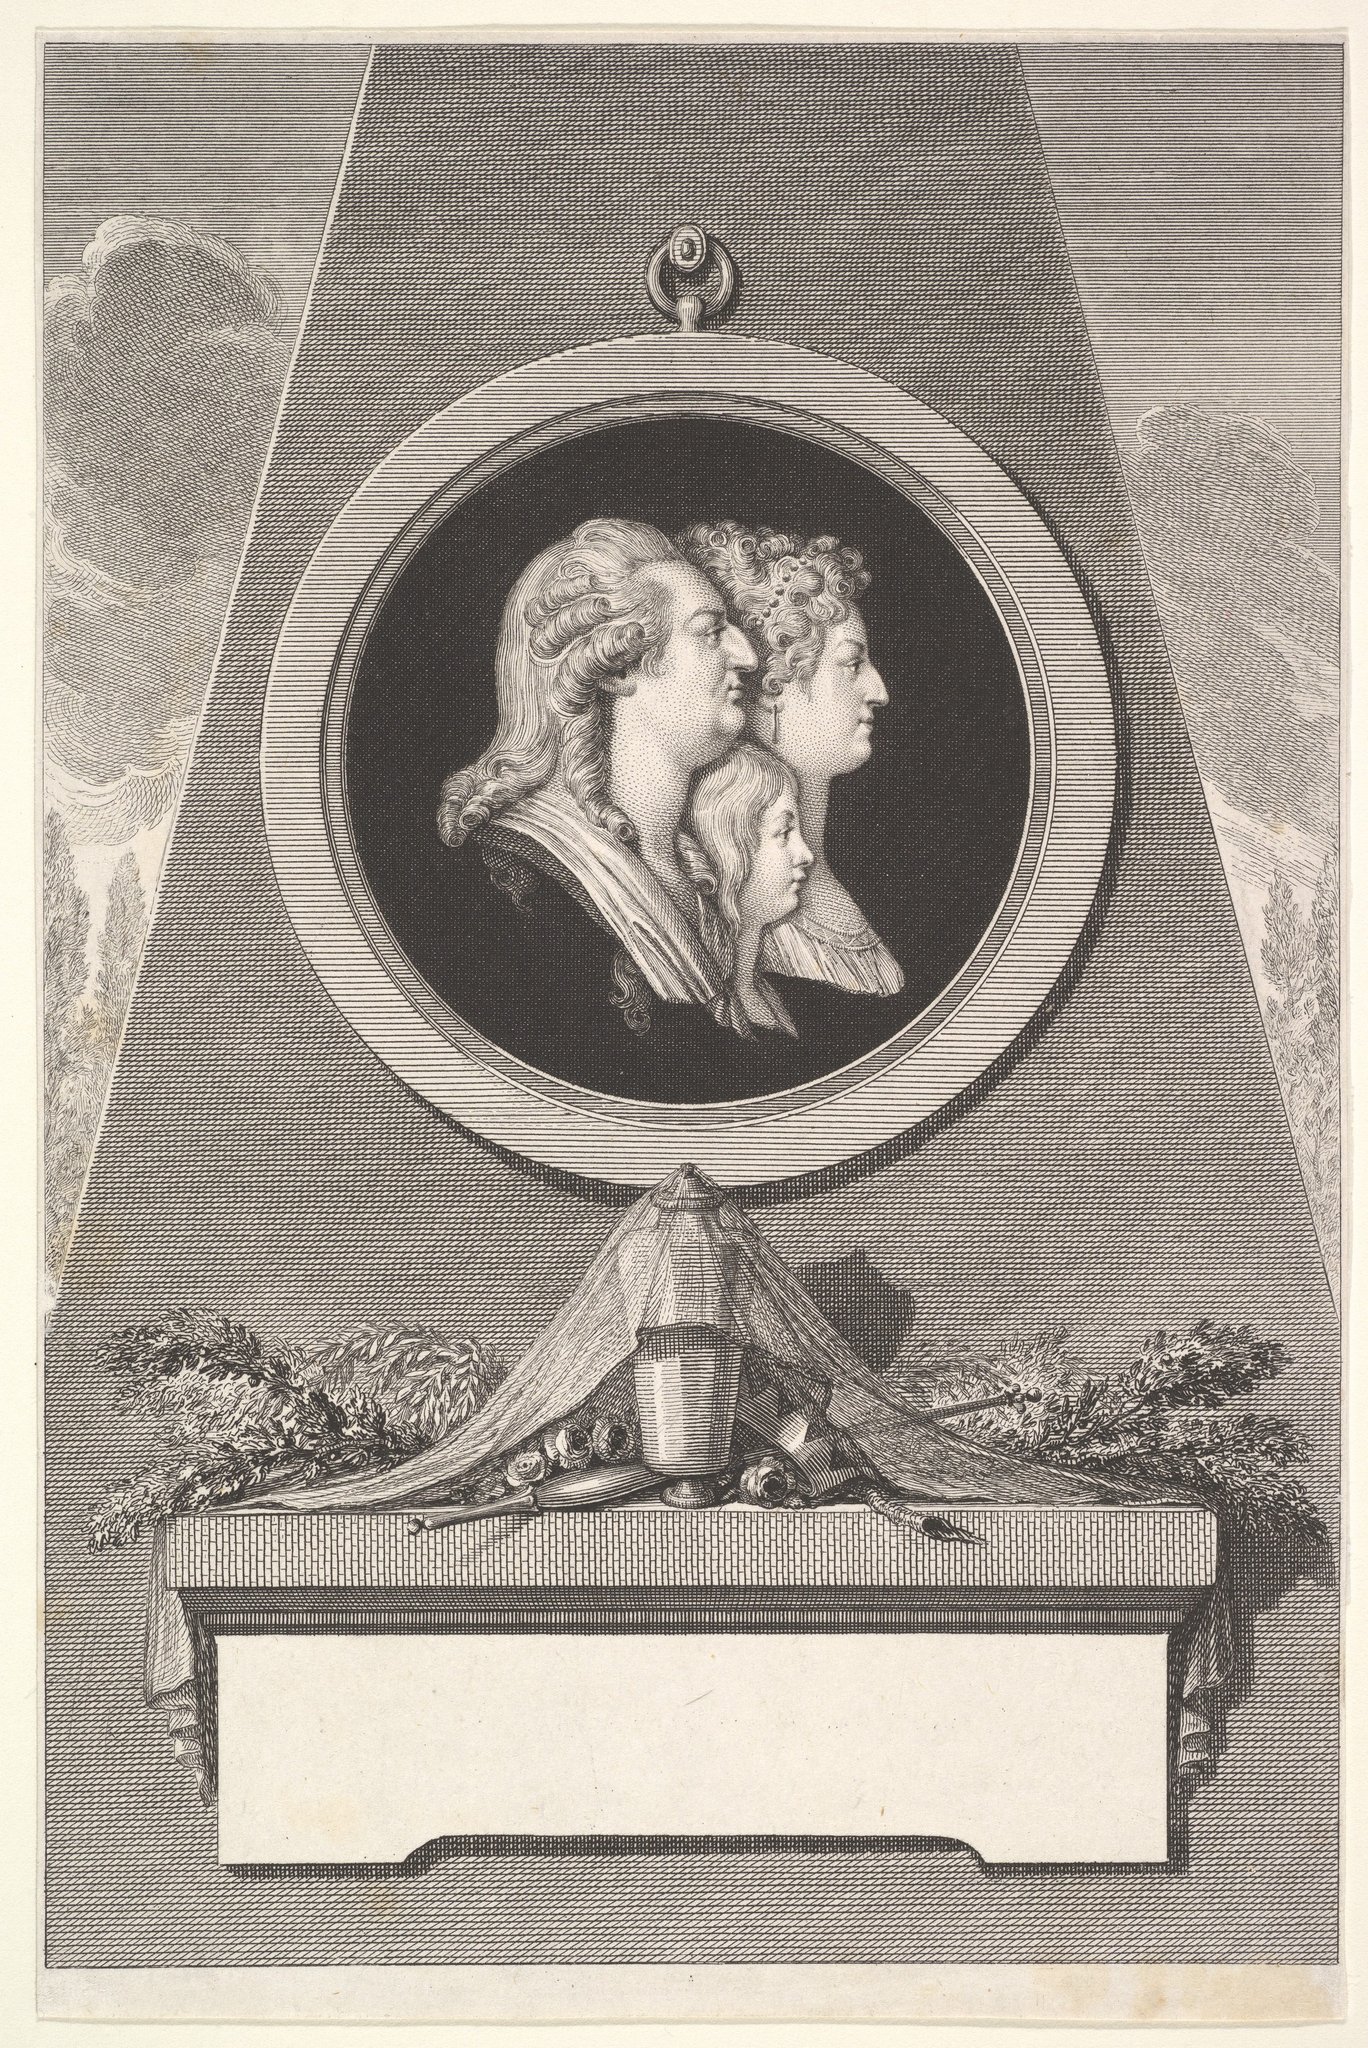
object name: print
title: Portrait of Louis XVI, Marie Antoinette and The Dauphin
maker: augustin de saint-aubin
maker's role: artist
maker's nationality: french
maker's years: 1736-1807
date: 1791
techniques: etching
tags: men,profiles,women